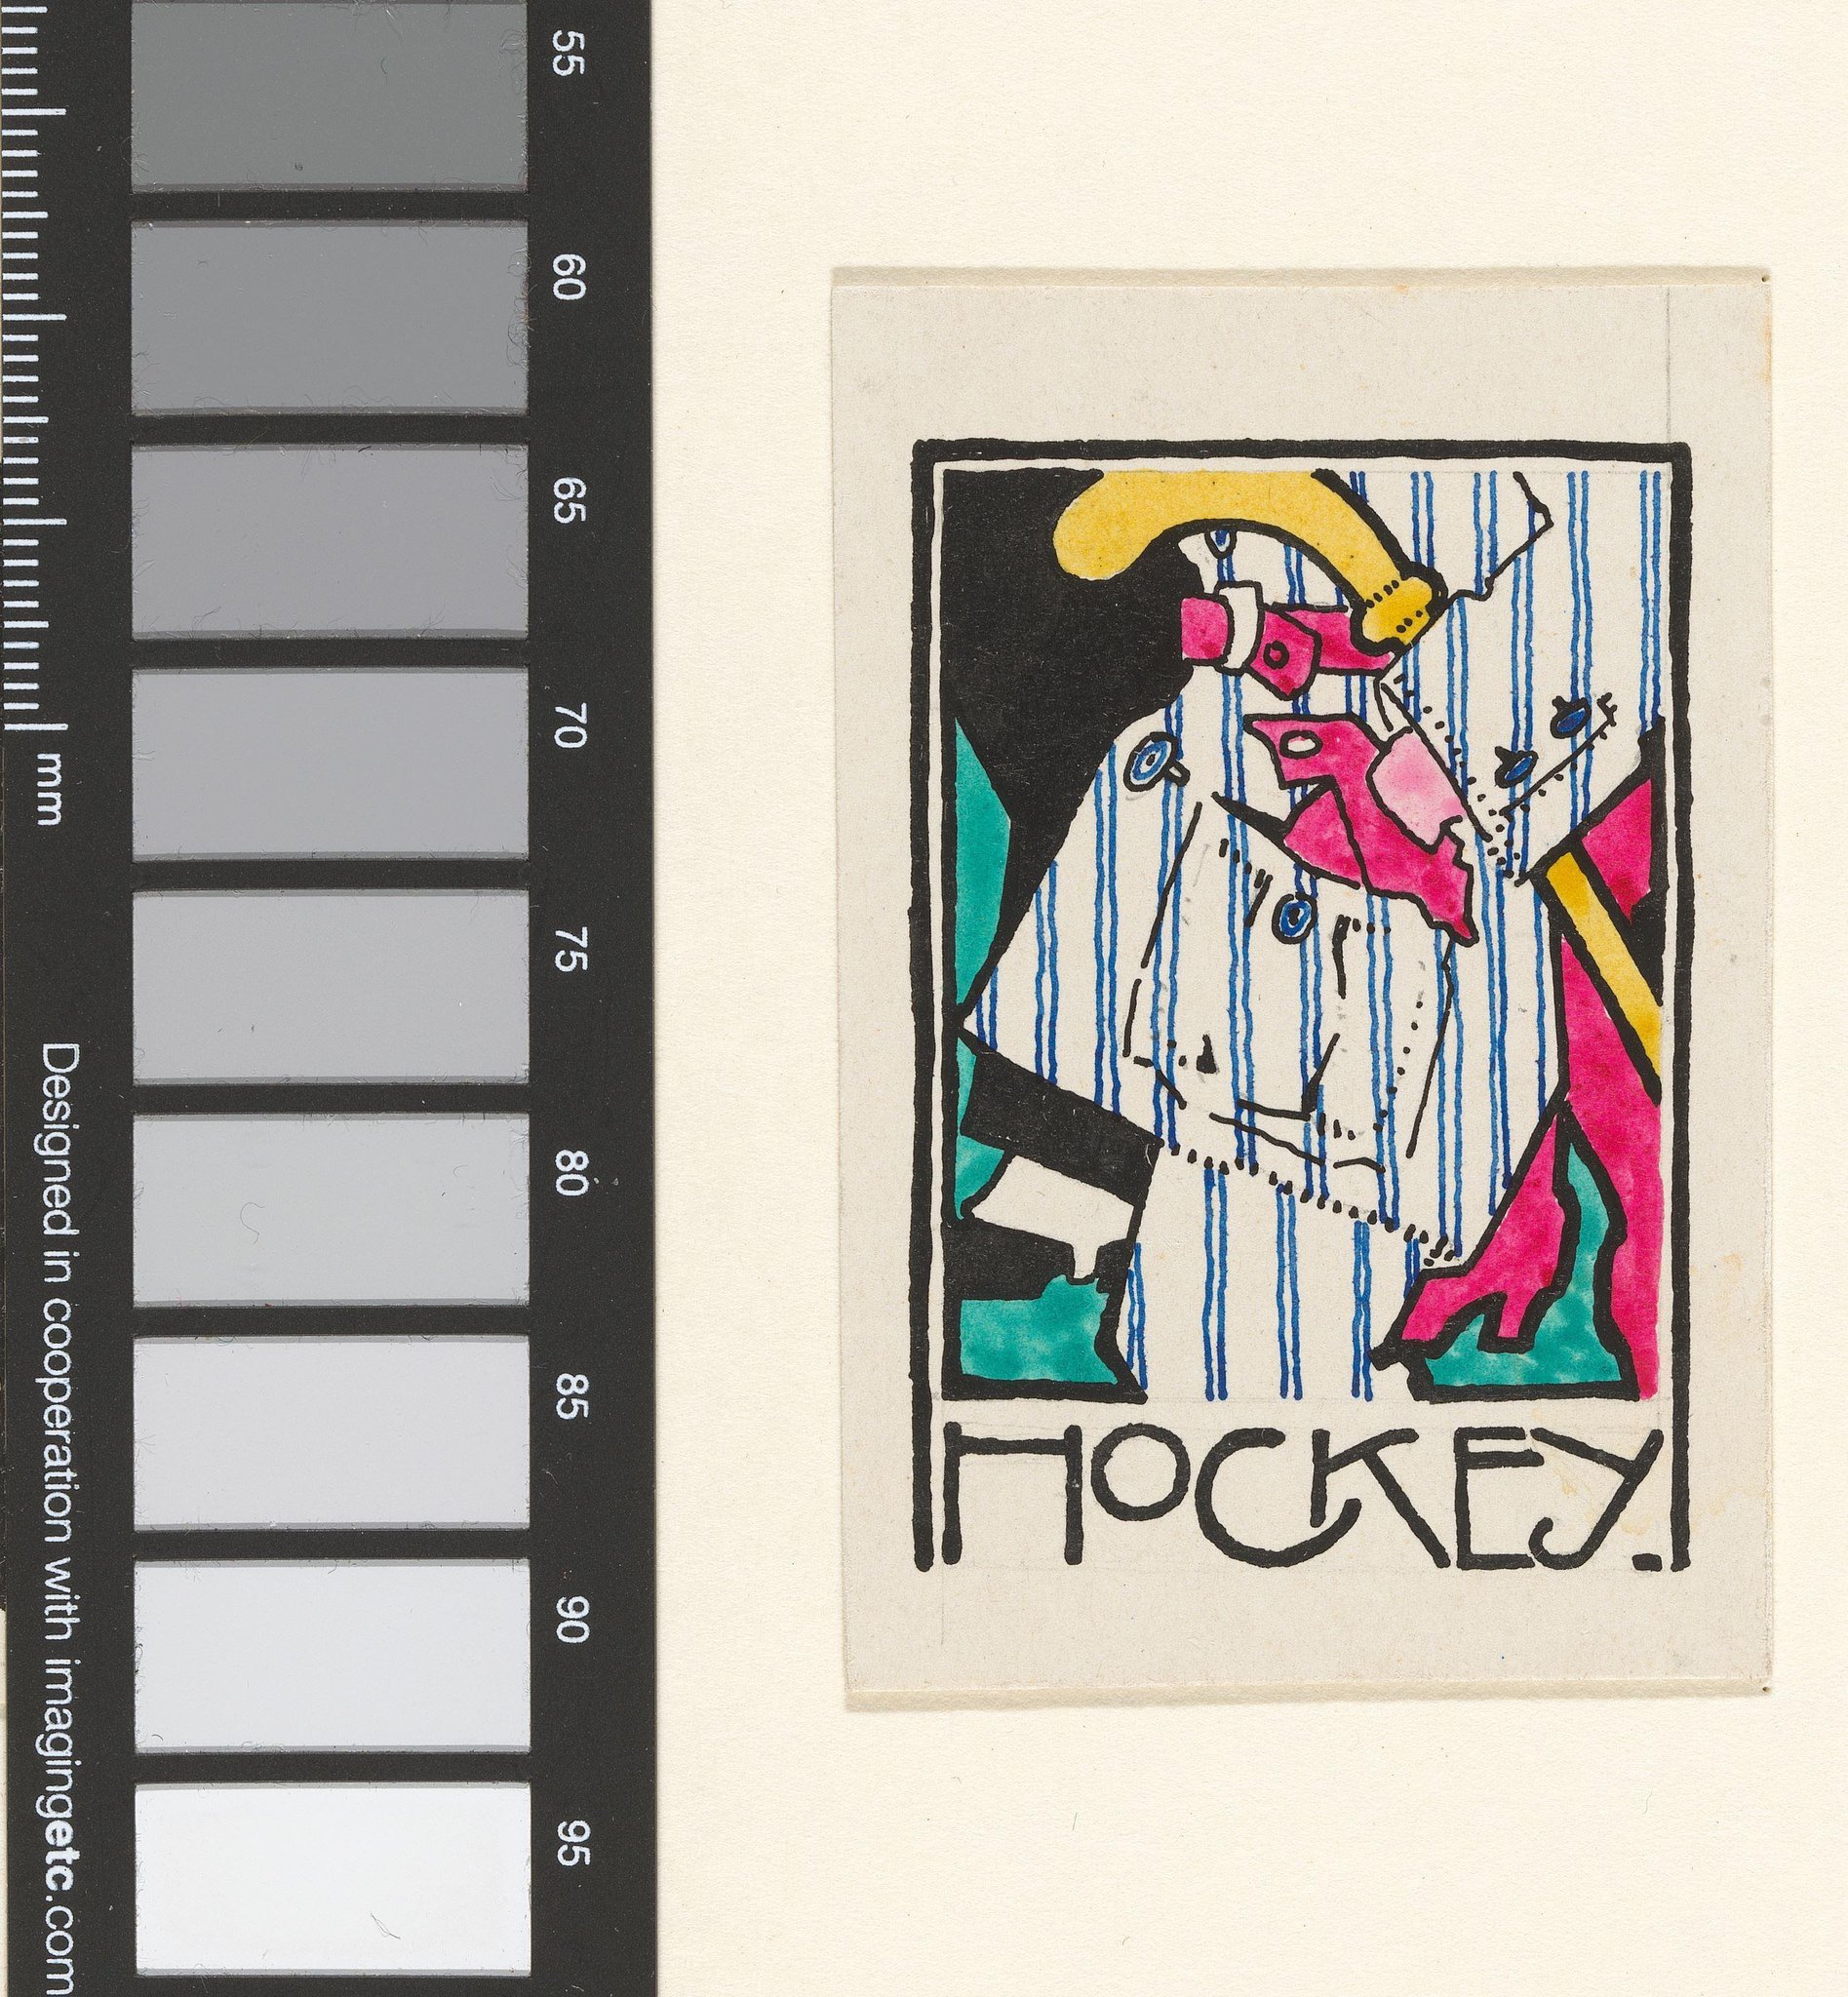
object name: drawing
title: Hockey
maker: reijer stolk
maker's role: draughtsman, print maker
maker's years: 1896-1945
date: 1906-1945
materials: ink, paper, pencil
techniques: brush, pen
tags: hockey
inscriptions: collector's mark: Lugt 2760, collector's mark: Lugt 2228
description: Deel van een figuur in een gestreept pak die een hockeystick onder zijn arm klemt.